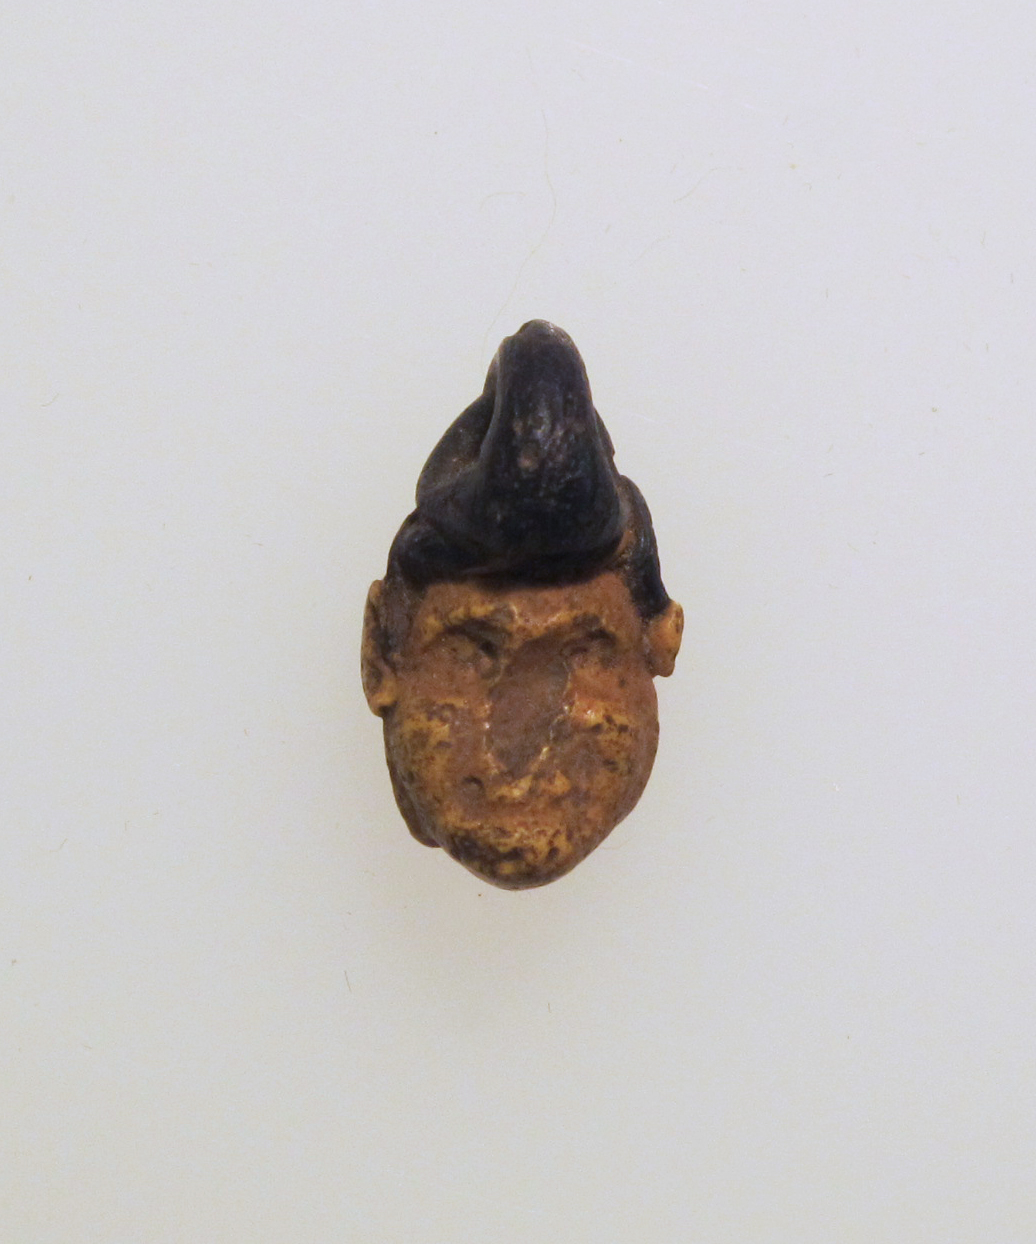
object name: head pendant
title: Glass head pendant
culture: carthaginian or eastern mediterranean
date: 300-1 BCE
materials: glass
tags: heads